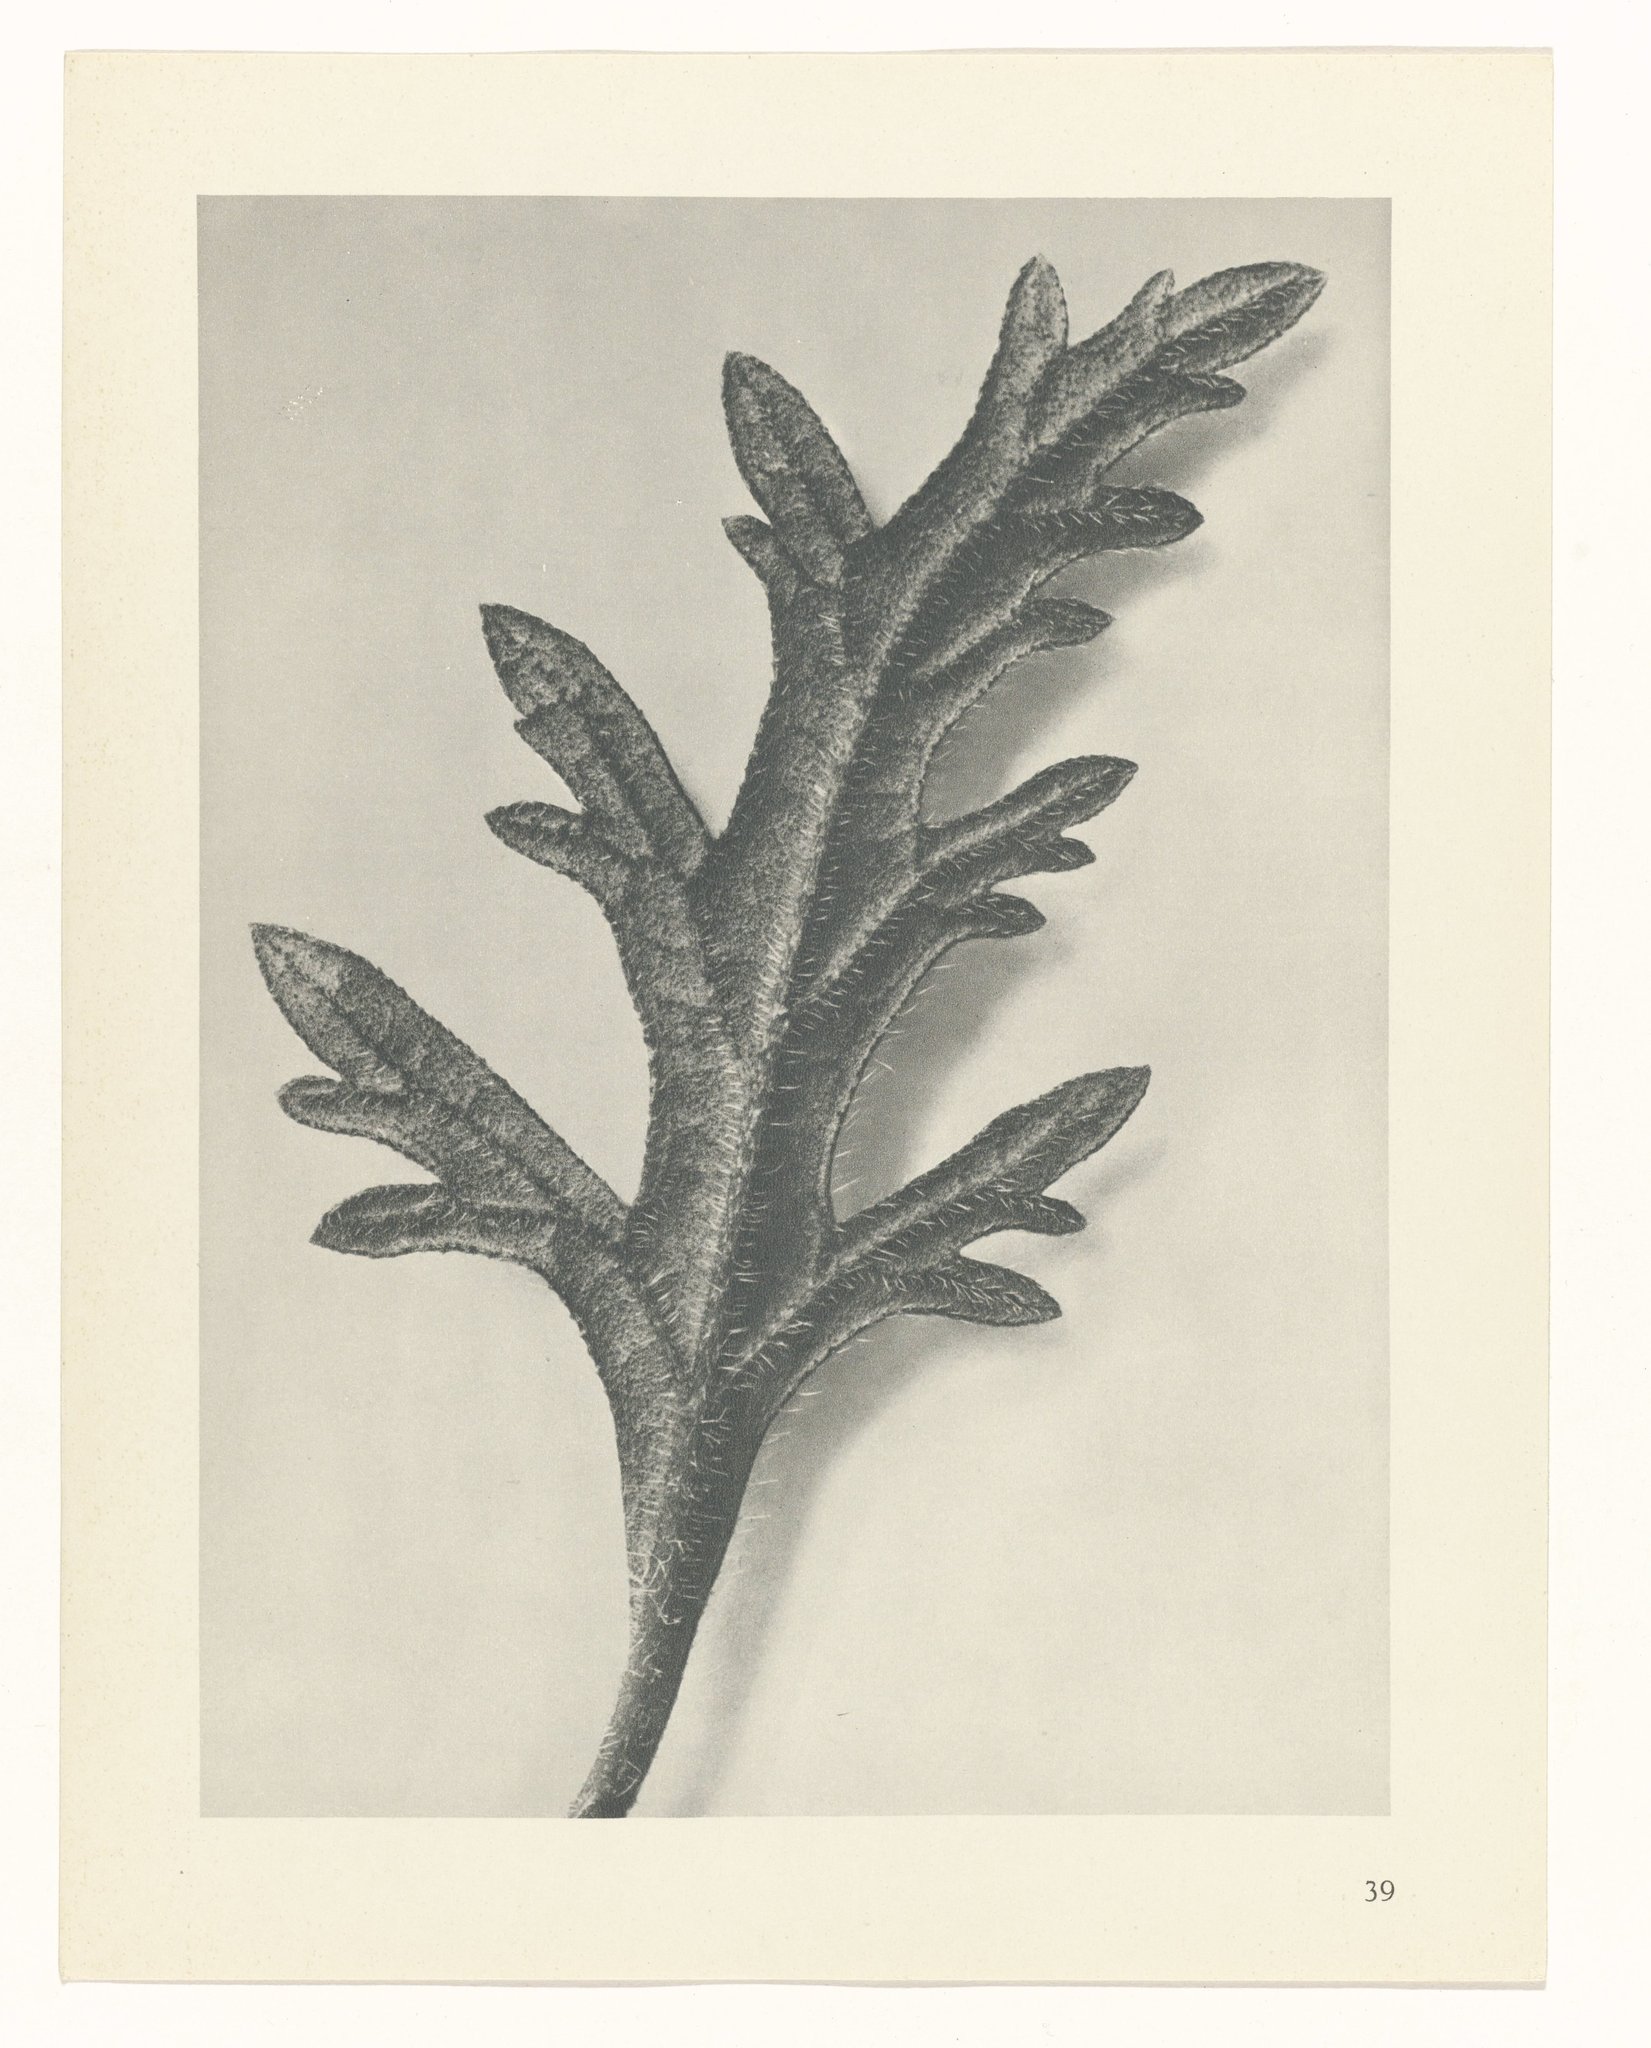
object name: photograph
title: Plantstudie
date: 1928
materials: ink, paper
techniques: rotogravure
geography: berlin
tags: plants (in general)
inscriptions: number: ‘39’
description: facher Vergrößerung. Afkomstig uit losbladige uitgave.